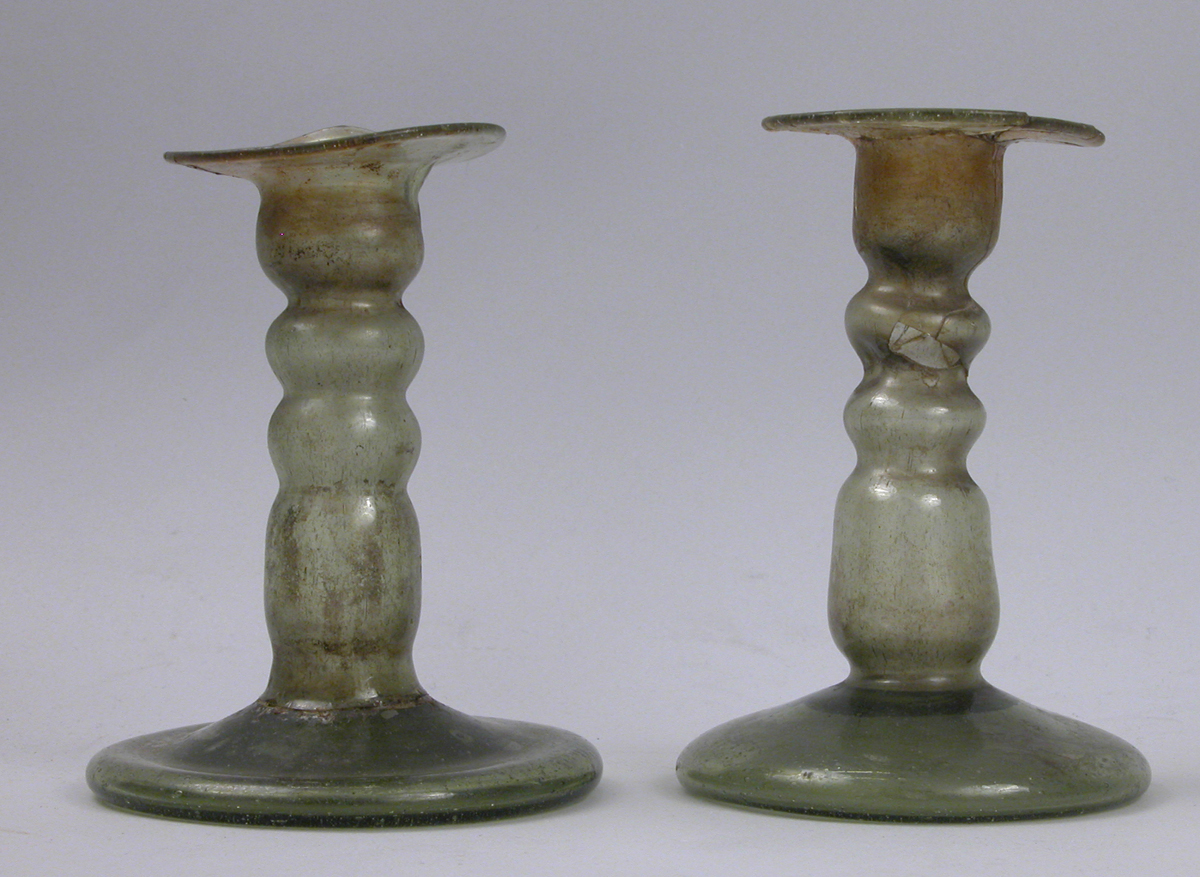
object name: candlestick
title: Candlesticks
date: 868-905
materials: glass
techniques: glassblowing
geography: egypt